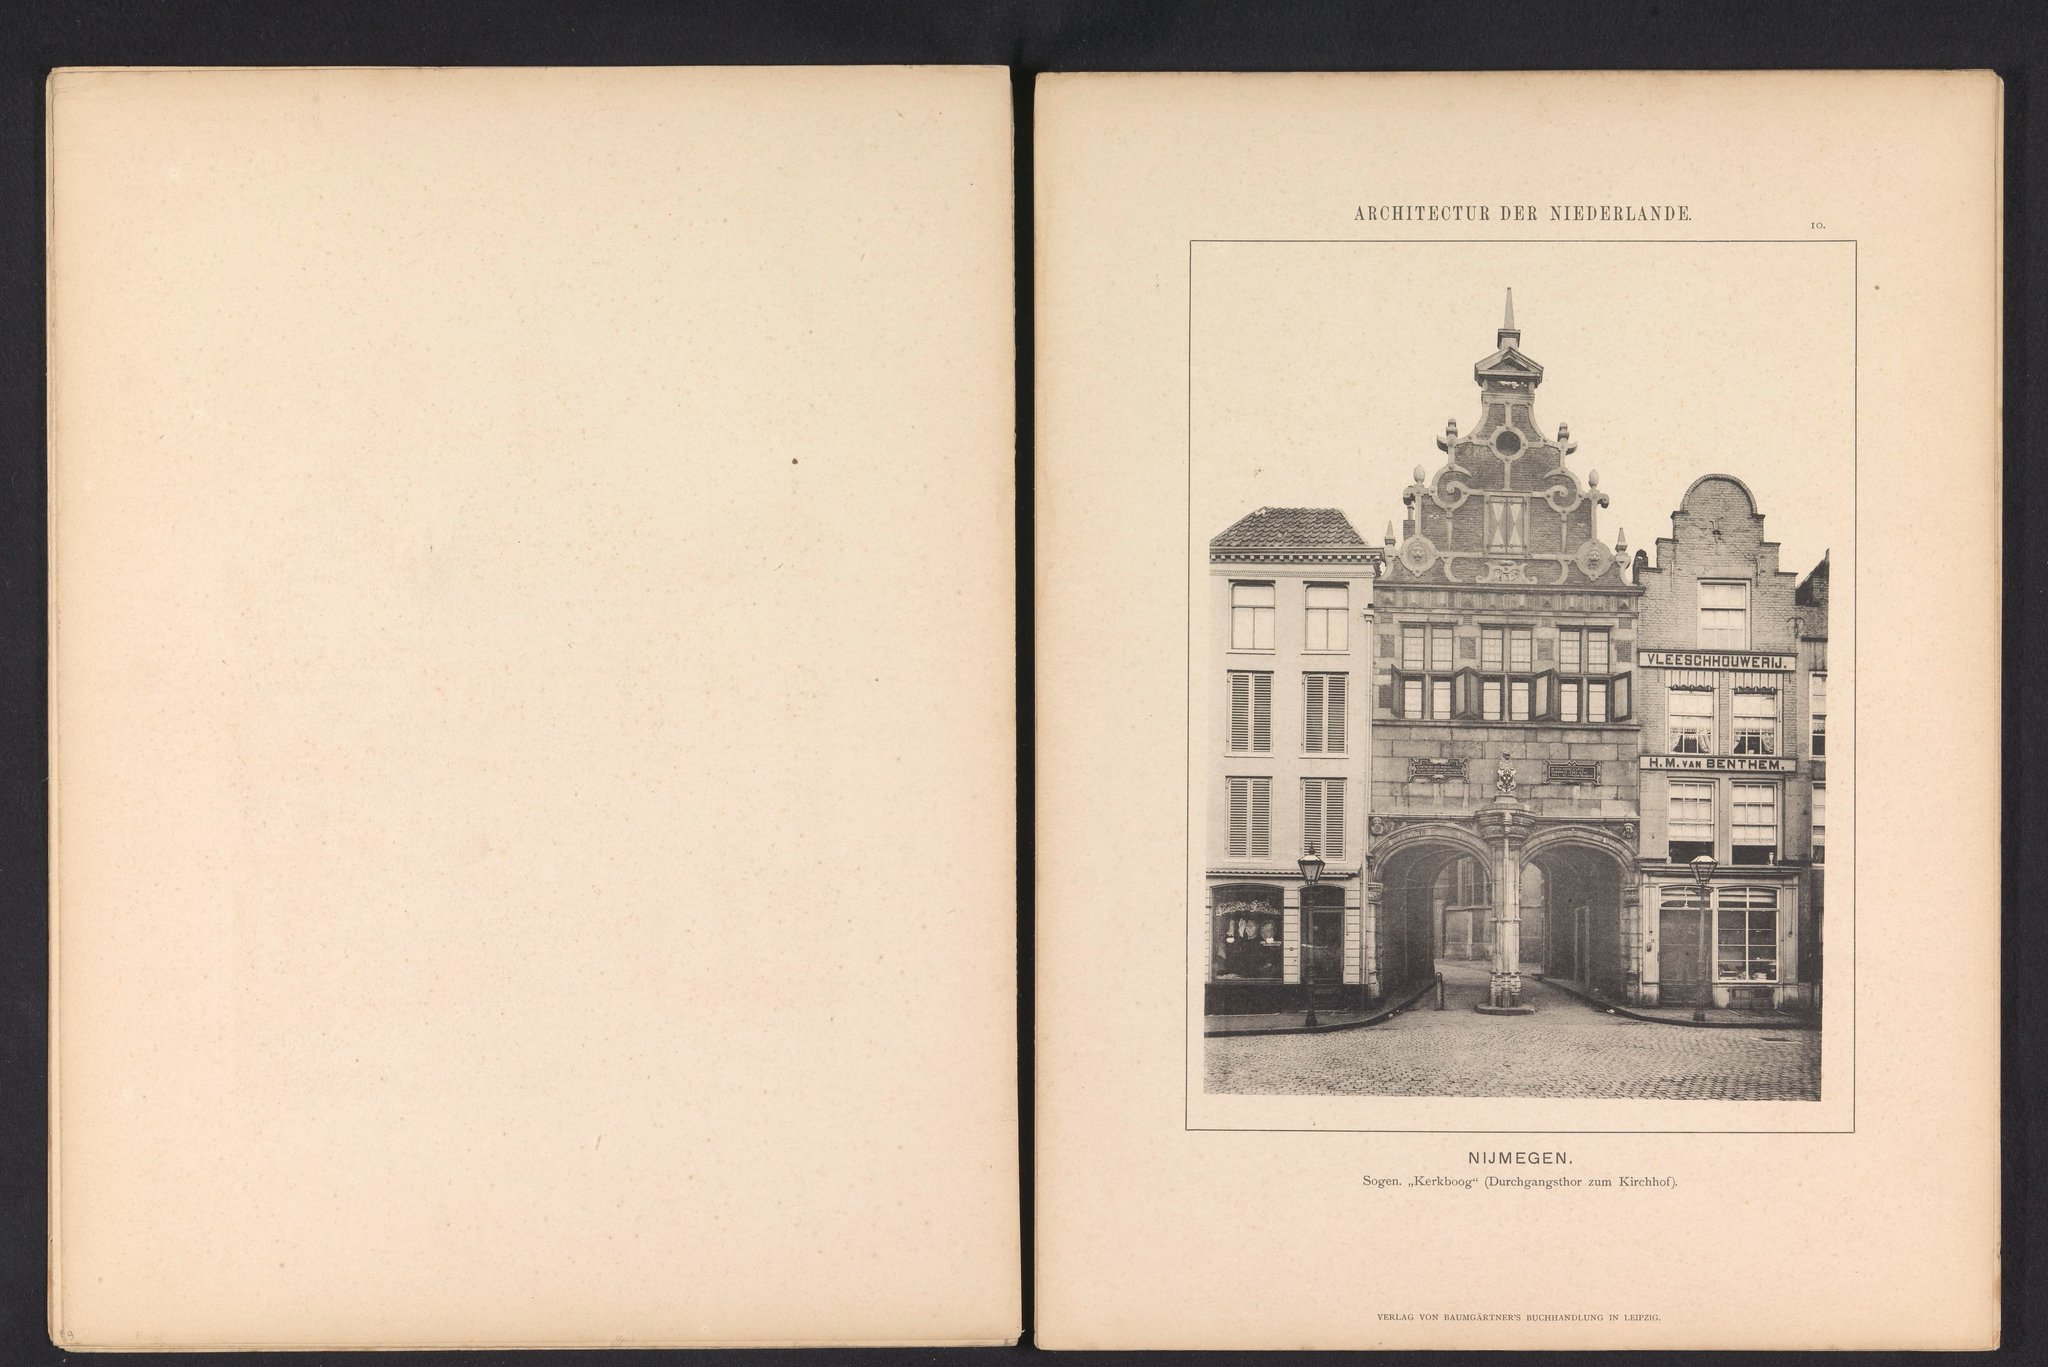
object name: photomechanical print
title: Architectur der Niederlande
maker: Anonymous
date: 1884-1894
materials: paper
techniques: photograph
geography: nijmegen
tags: gate, entrance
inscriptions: number: ‘10.’